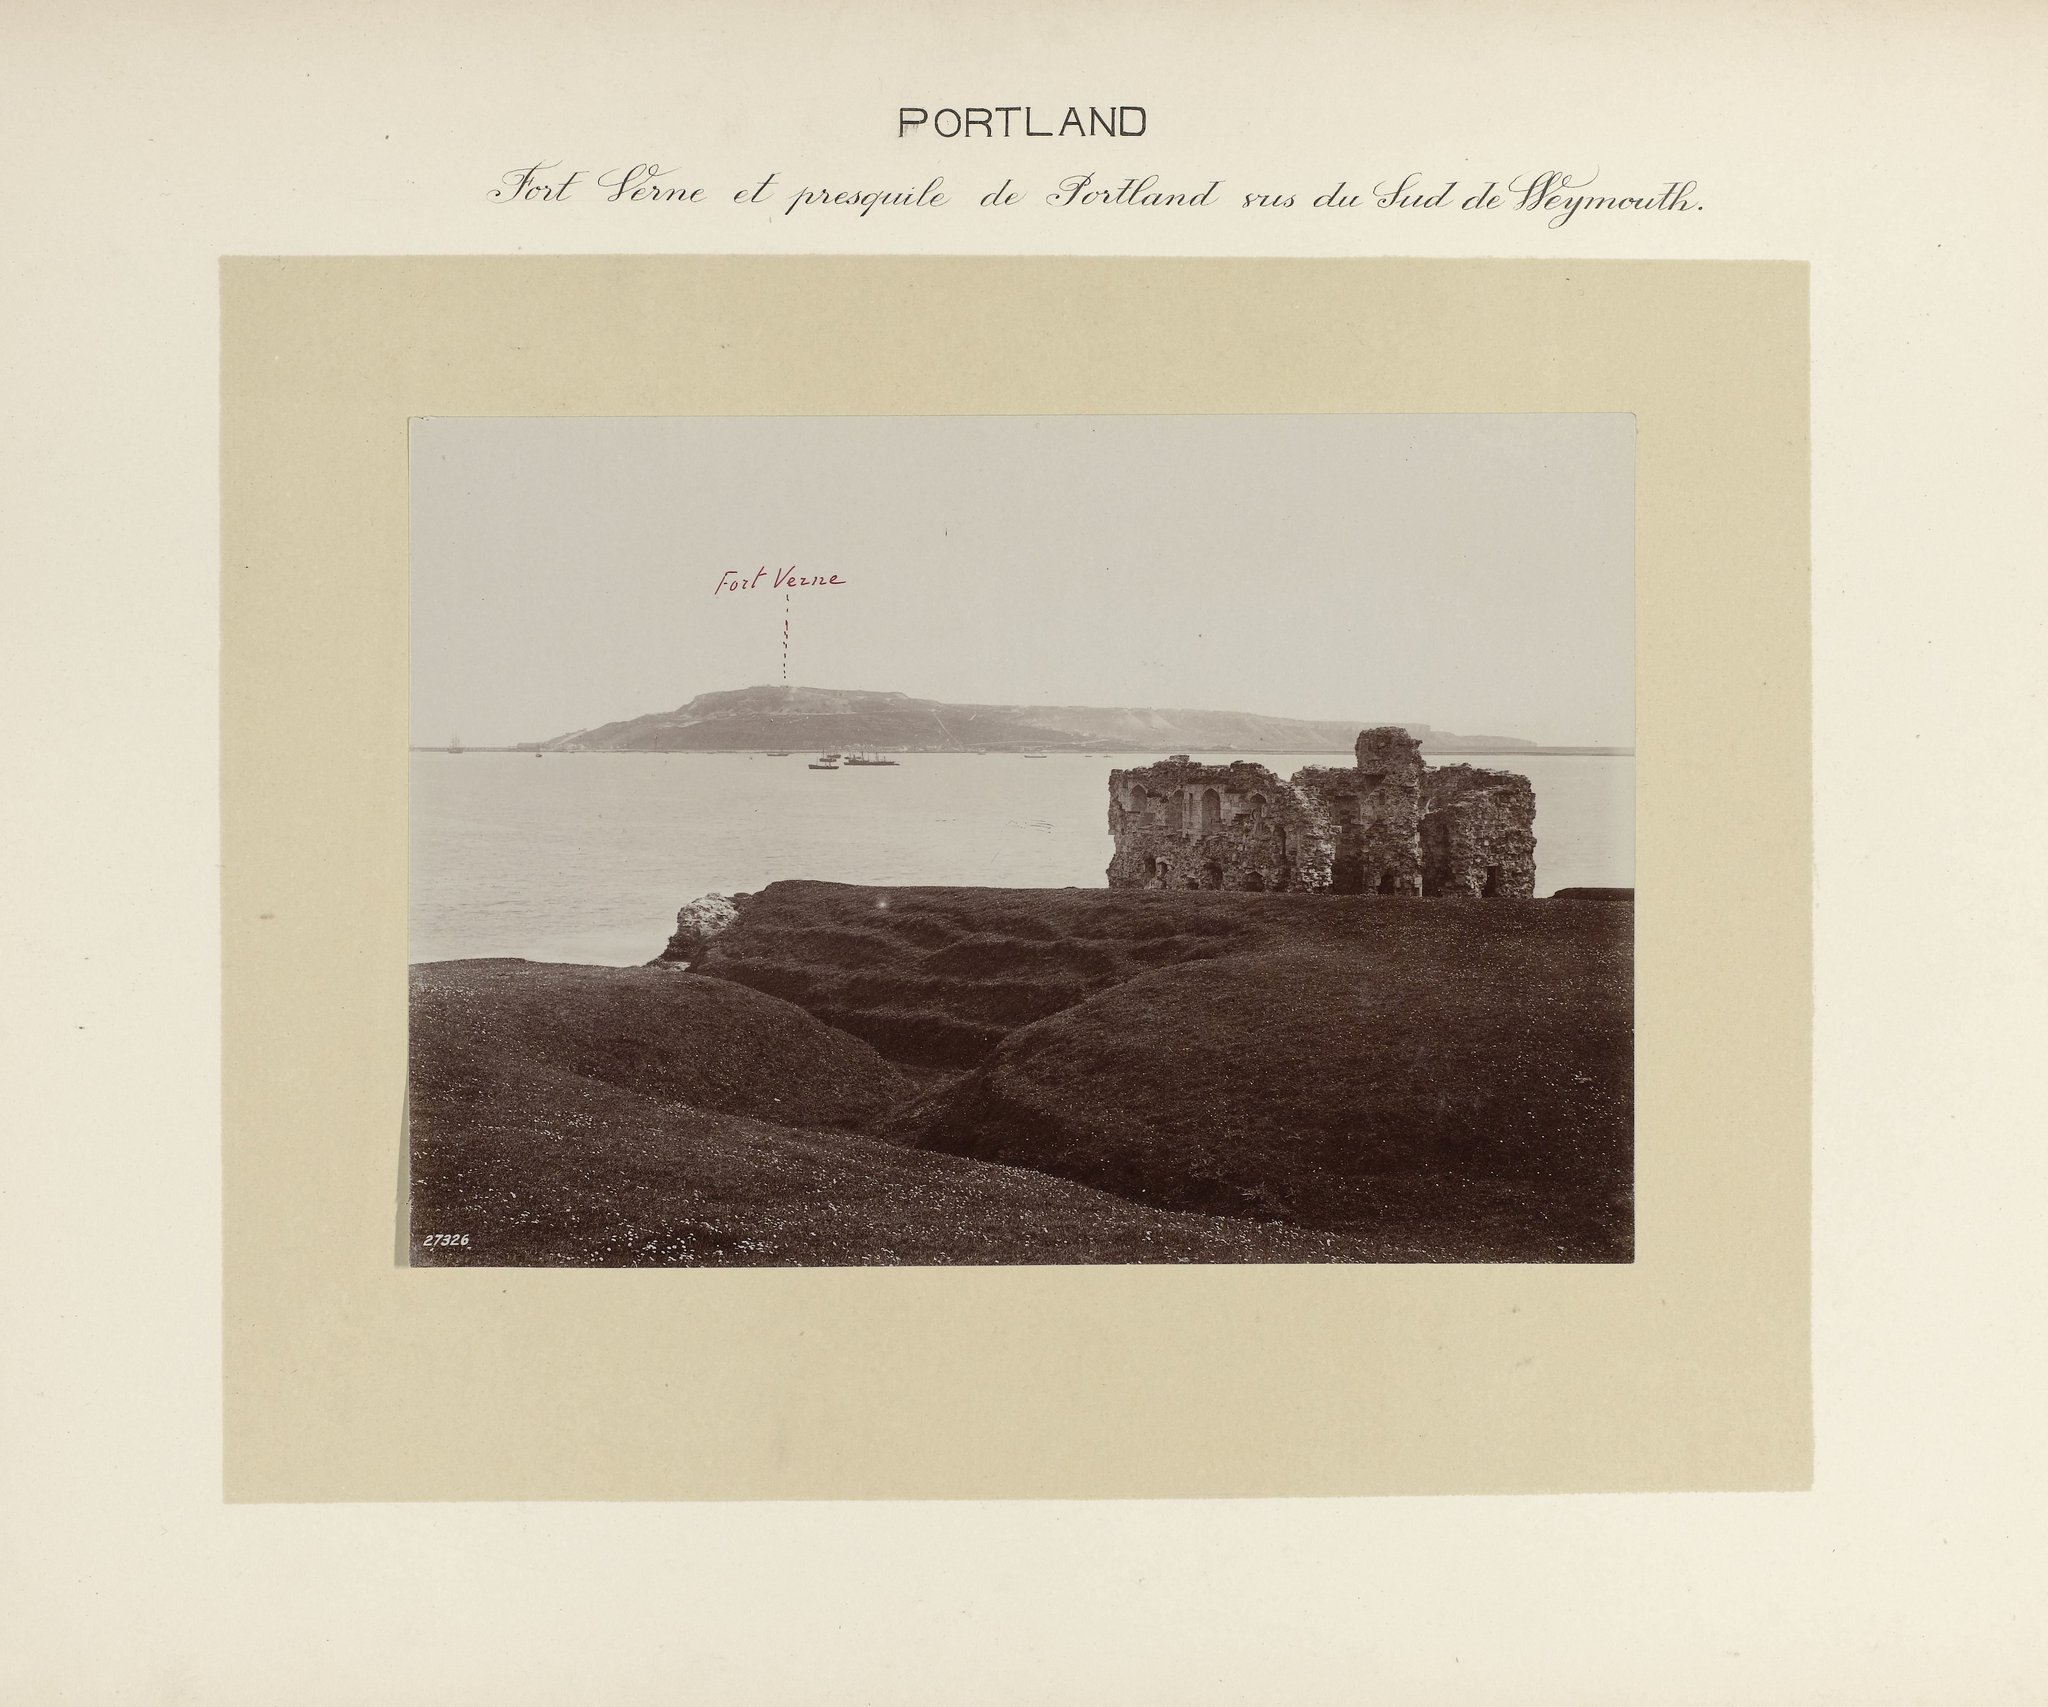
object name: photograph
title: Gezicht op het schiereiland van Portland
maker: Anonymous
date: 1891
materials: cardboard, paper, photographic support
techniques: albumen print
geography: great britain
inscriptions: annotation: ‘Fort Verne’, number: ‘27326’, inscription: ‘PORTLAND / Fort Verne et presquile de Portland vus du Sud de Weymouth’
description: Foto uit een album met 35 topografische foto's van Britse kustplaatsen, waarop in pen militaire verdedigingswerken zijn aangegeven door een Franse militair.